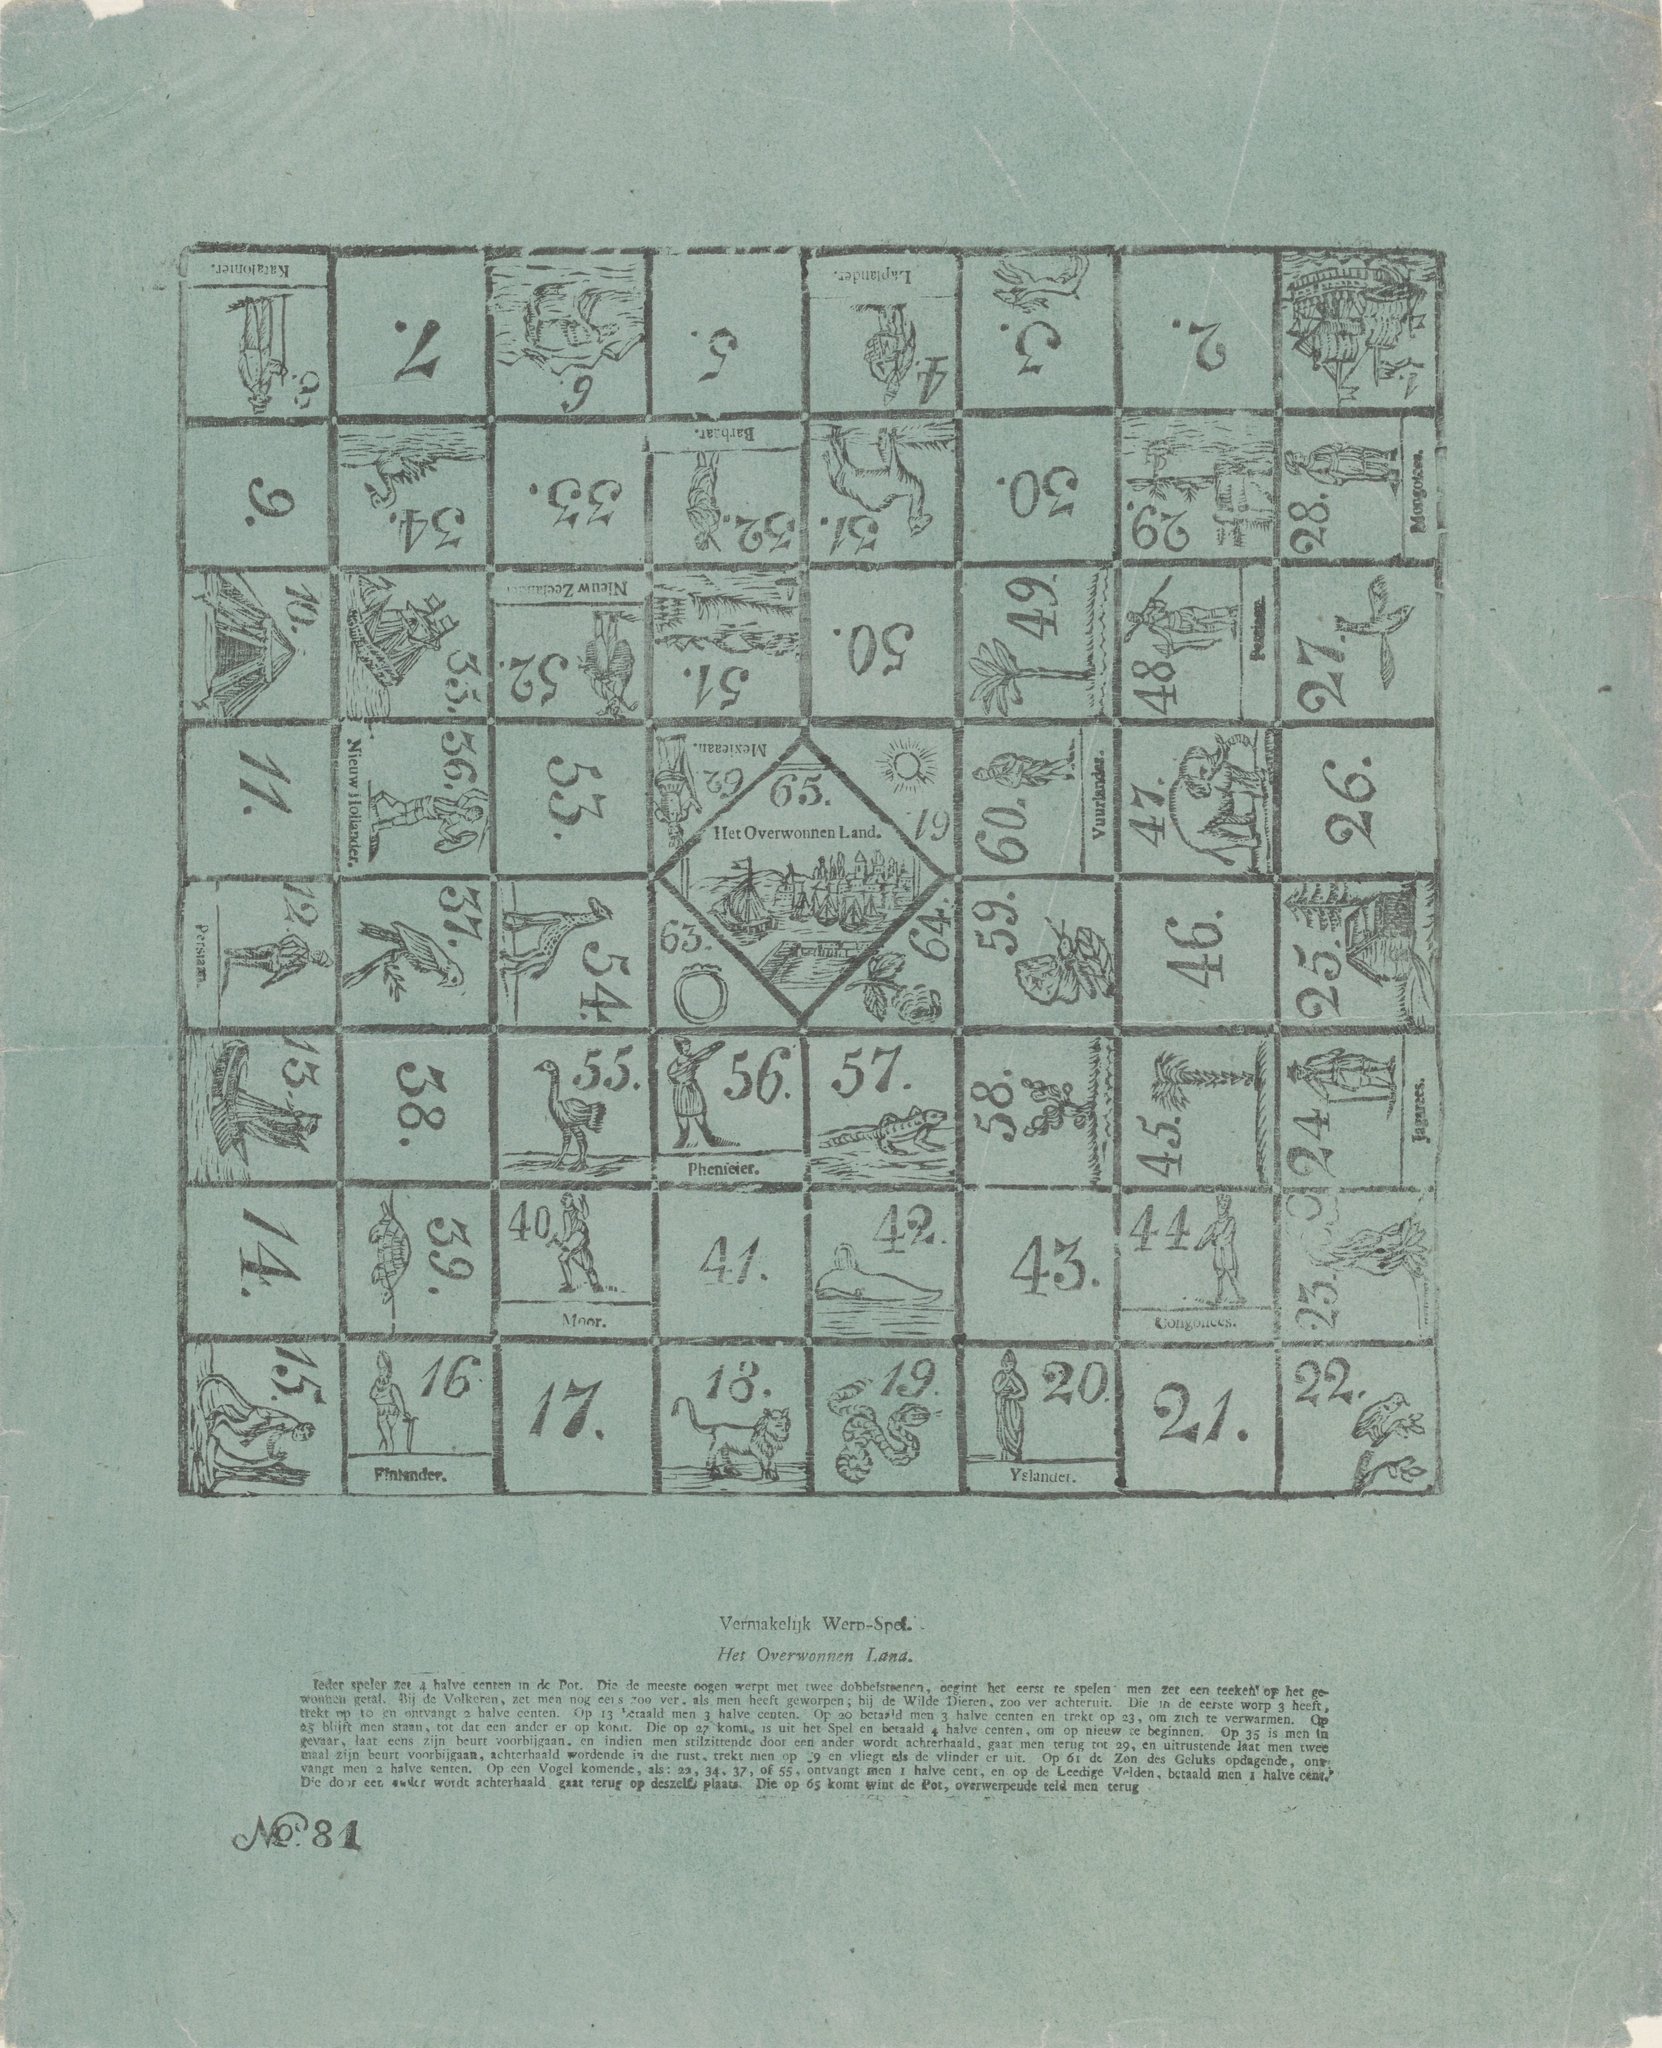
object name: print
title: Vermakelijk werp-spel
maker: Anonymous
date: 1700-1899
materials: paper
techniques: colour, letterpress printing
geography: netherlands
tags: board-games of chance, board-games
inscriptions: collector's mark: Lugt 2760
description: Bordspel met 65 genummerde vakjes. In de ondermarge de spelregels in boekdruk. Genummerd linksonder: No. 81.